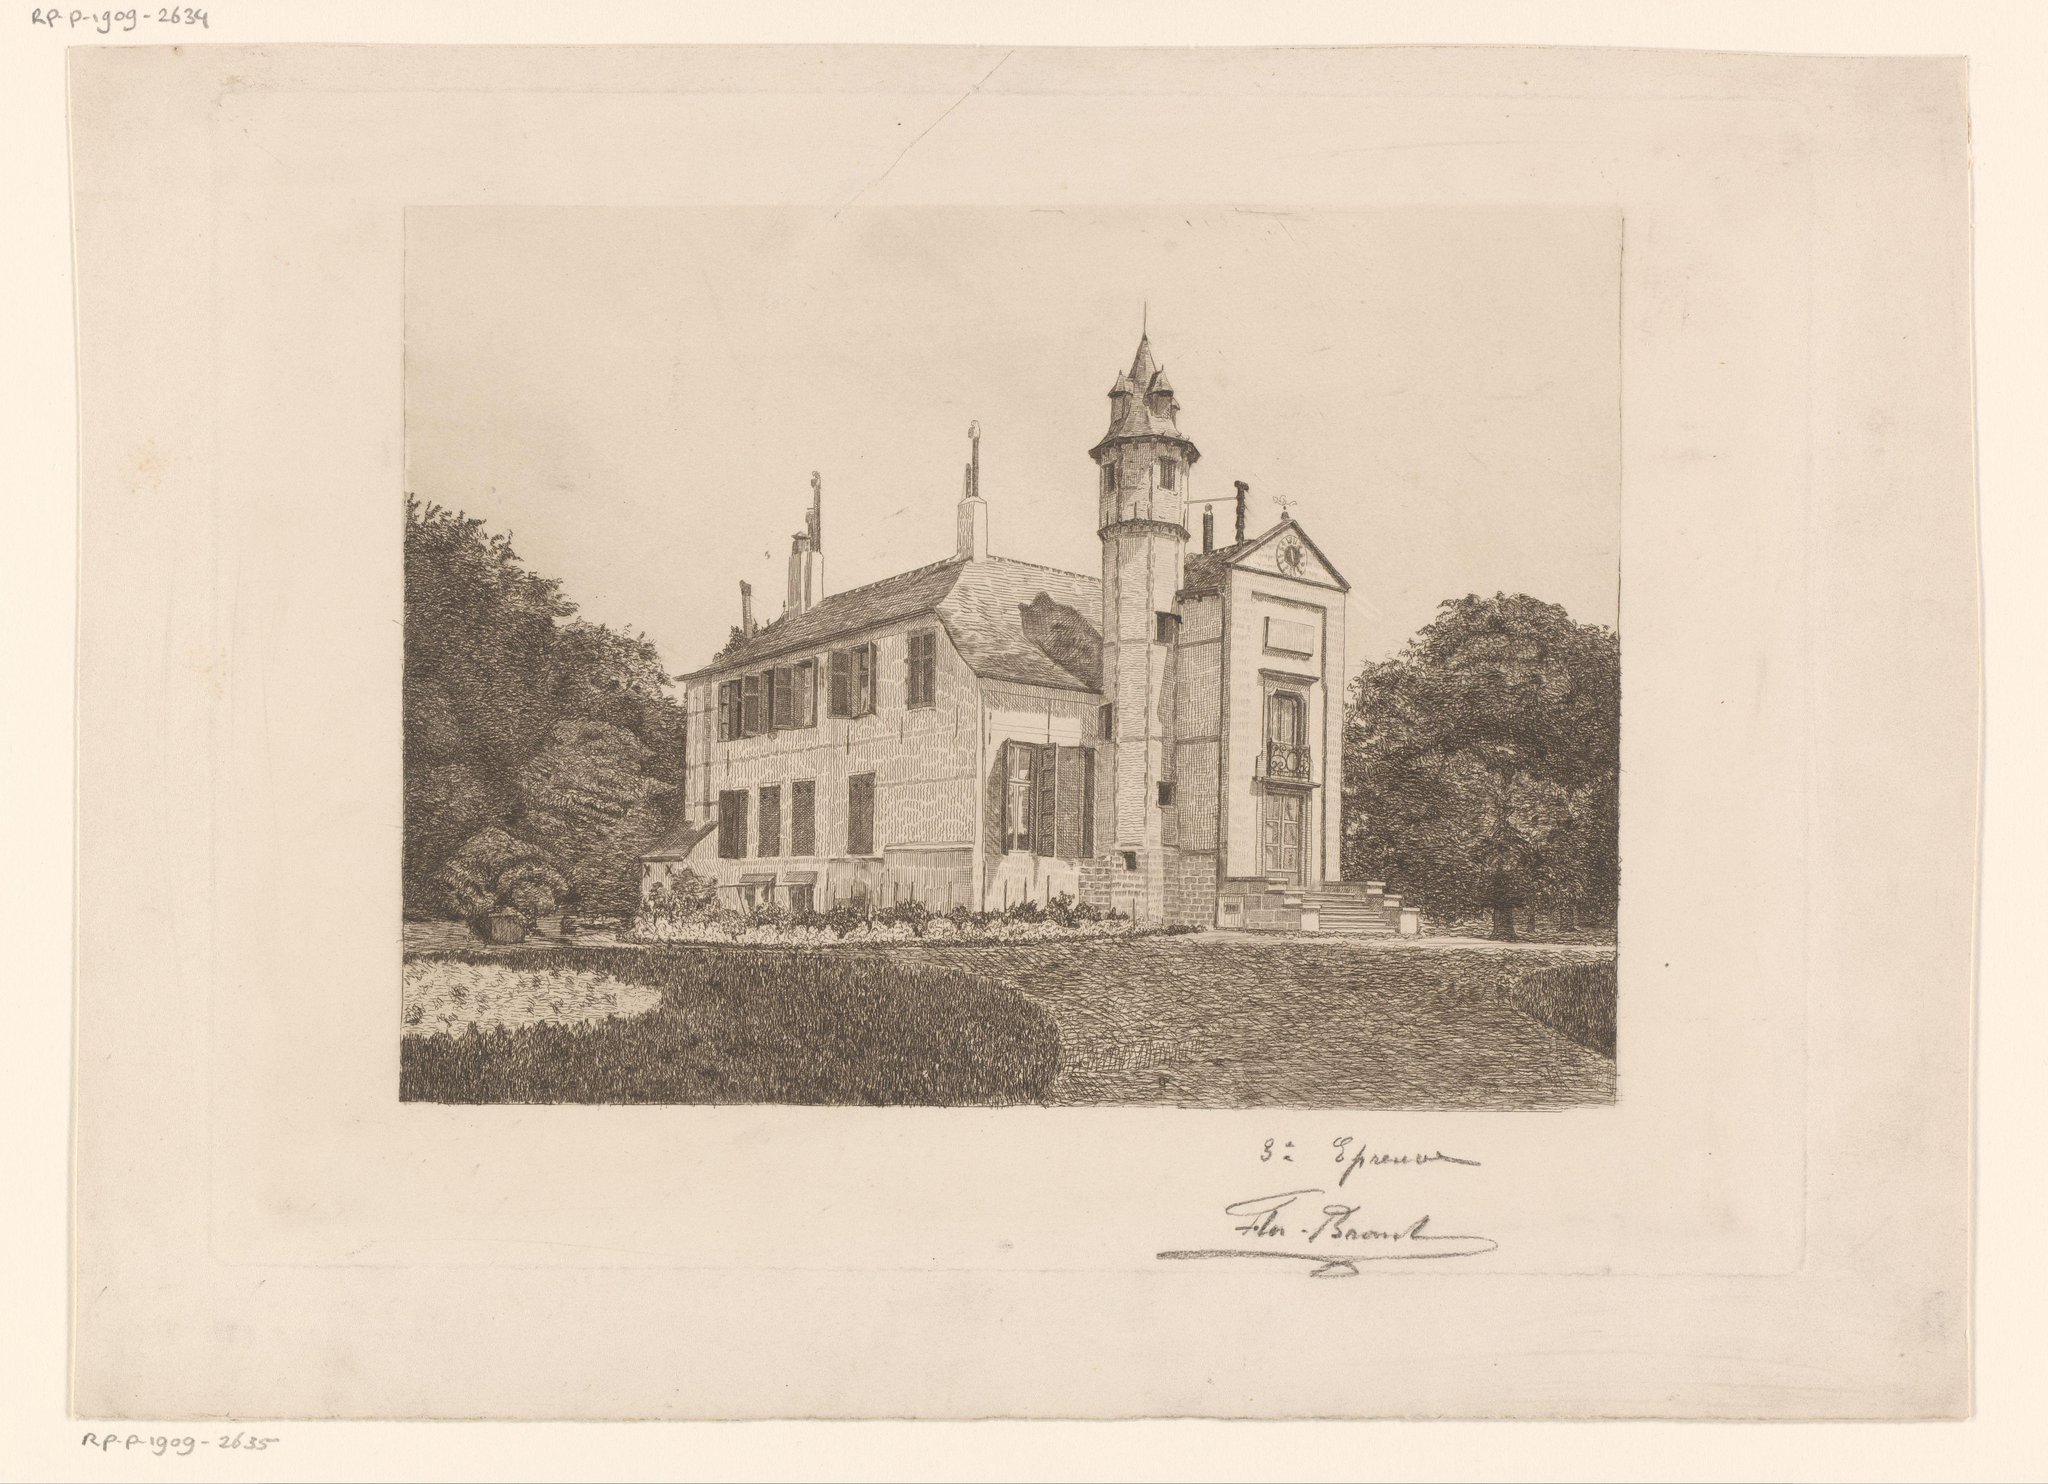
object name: print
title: Gezicht op een kasteel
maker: florent brant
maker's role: print maker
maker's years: 1863-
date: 1873-1909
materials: paper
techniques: etching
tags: castle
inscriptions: inscription: ‘3e Epreuve’, collector's mark: Lugt 2228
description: Opschrift in potlood eerdere staat: Calenberg/Catenberg.